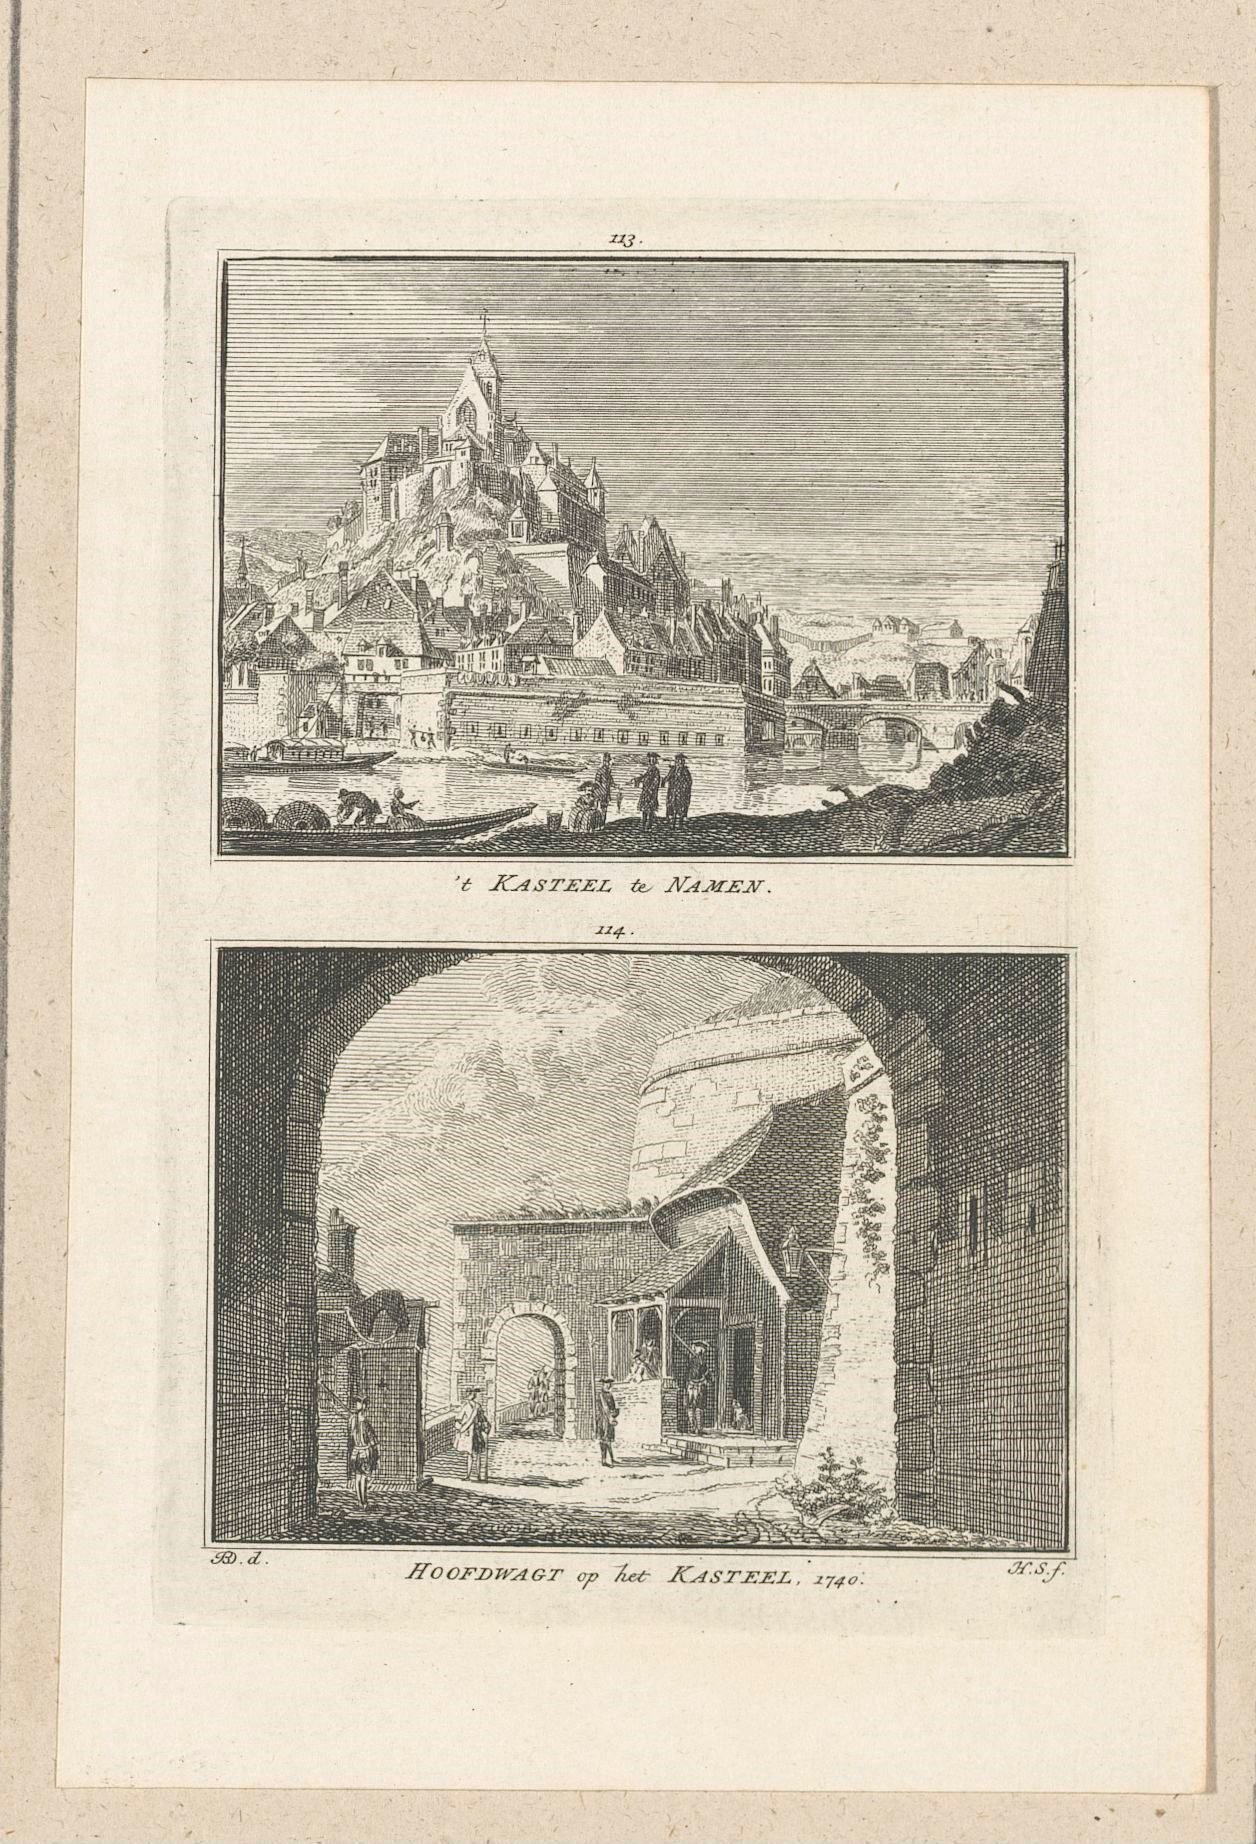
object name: print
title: 't Kasteel te Namen / Hoofdwacht op het Kasteel, 1740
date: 1746-1792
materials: paper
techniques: engraving, etching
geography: haarlem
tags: market, prospect of city, town panorama, silhouette of city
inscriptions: collector's mark: Lugt 2228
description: Prent ook gebruikt in: Het verheerlykt Nederland of kabinet van hedendaagsche gezigten van steden, dorpen (…). 9 delen. Amsterdam: Isaak Tirion en weduwe Isaak Tirion, 1745-1774, dl. 2 (1746), ill. 113-114. Of in: Nederlandsche tafereelen; of eene keurige verzameling van negen honderd fraaije gezigten van steden, dorpen, sloten, oudheden (…). 9 delen. Amsterdam: Jan de Groot, 1792, dl. 2, ill. 113-114.